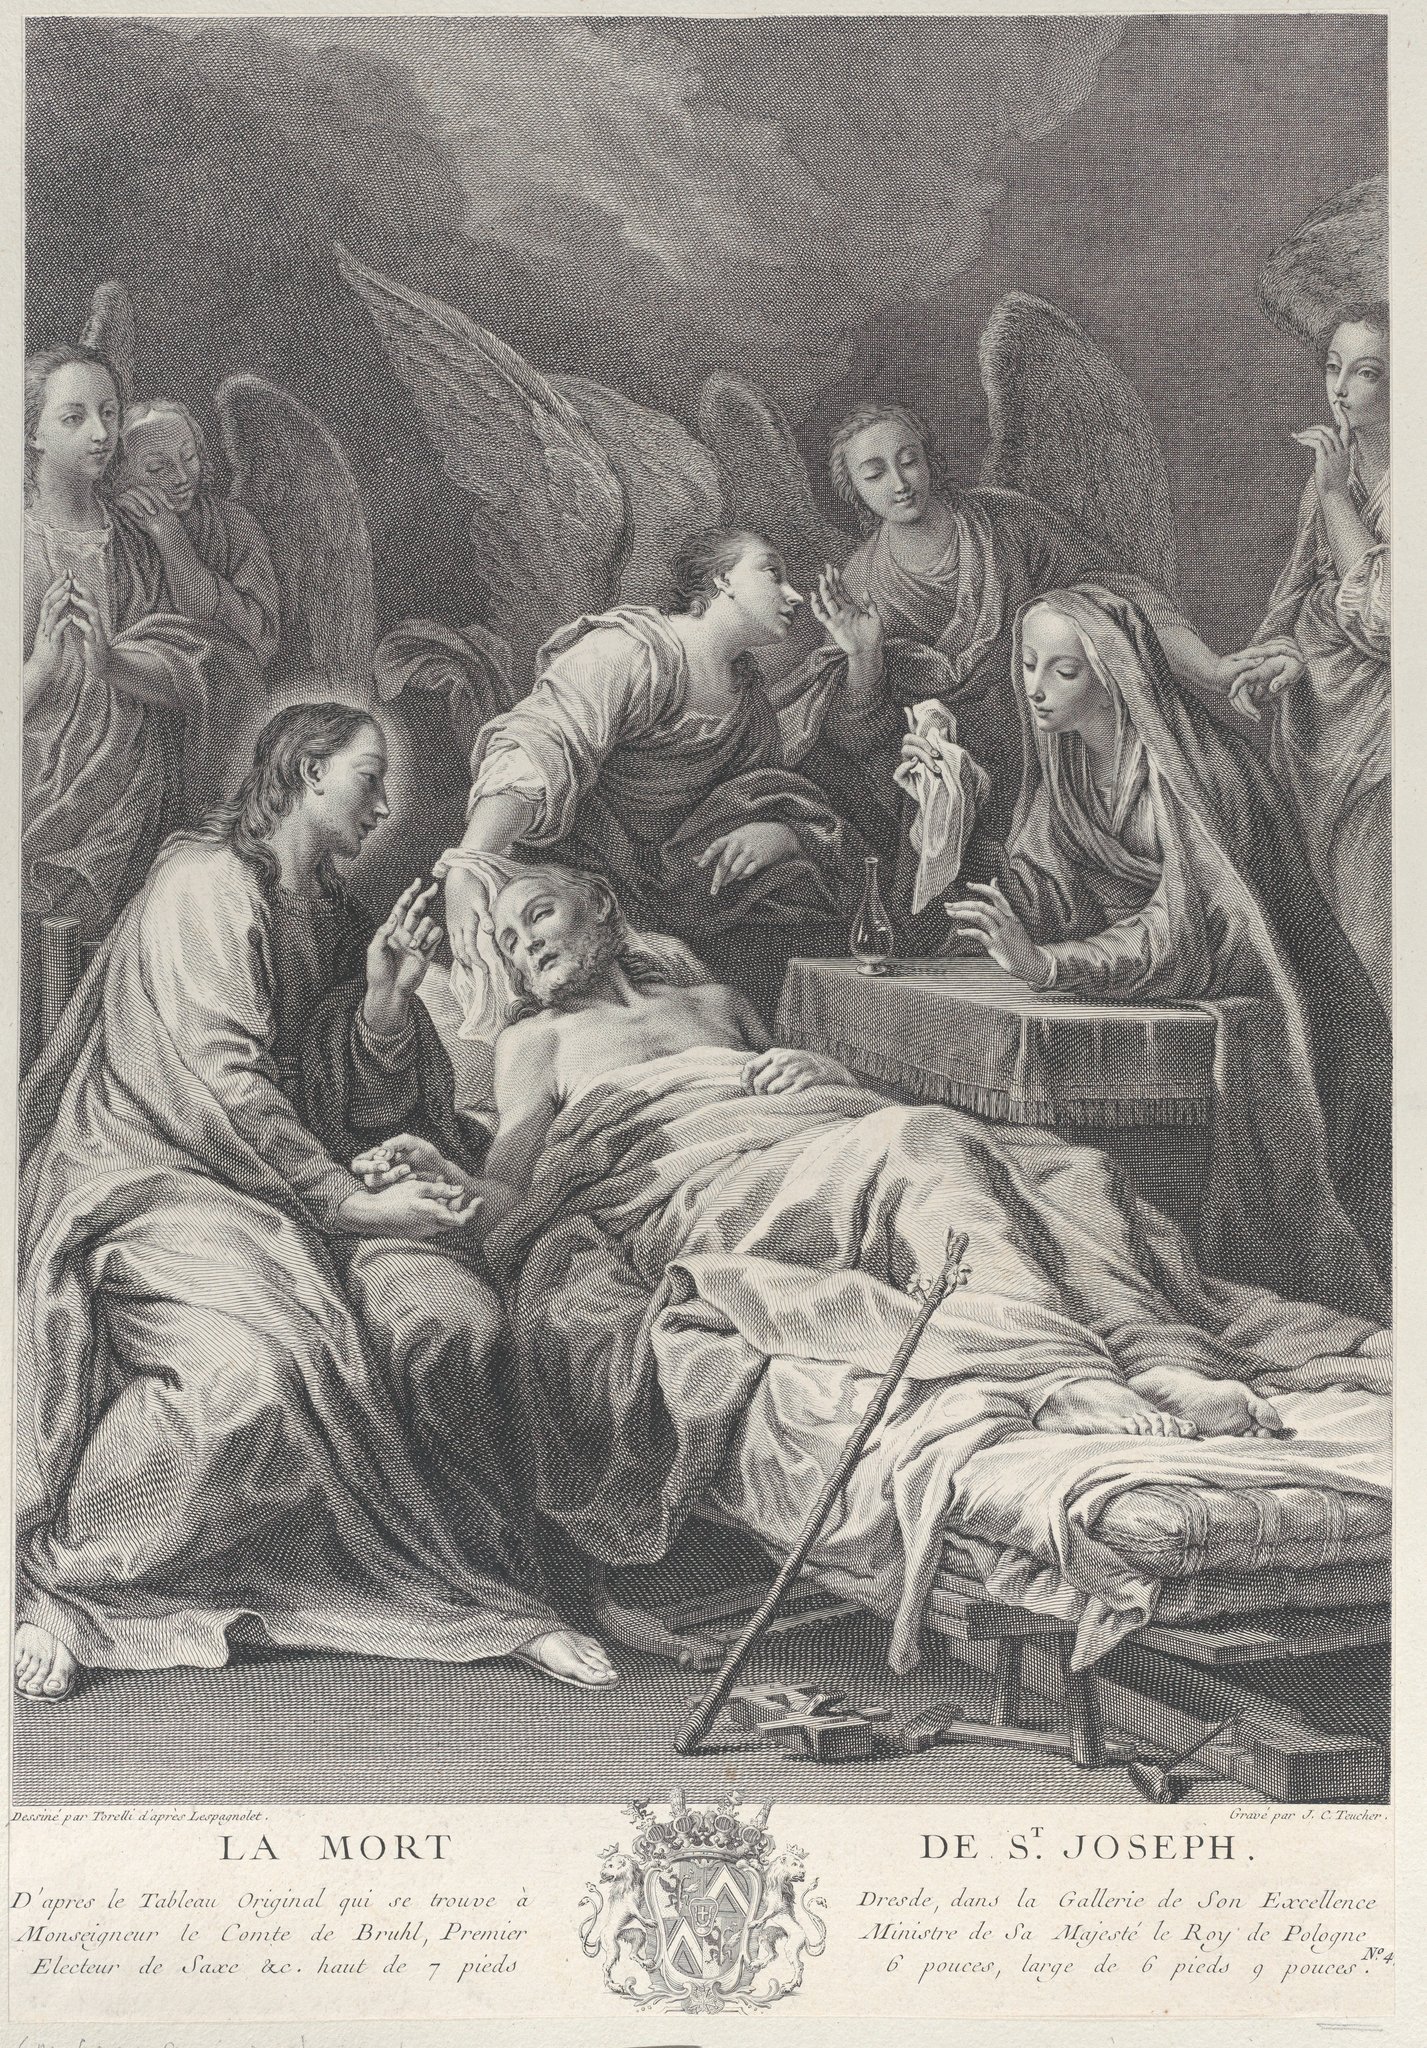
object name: print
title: The death of Saint Joseph, lying on a bed, with Jesus, the Virgin Mary, and angels at his side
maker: johann christian teucher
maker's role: artist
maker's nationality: german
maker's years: 1716-1750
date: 1740-1750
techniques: etching